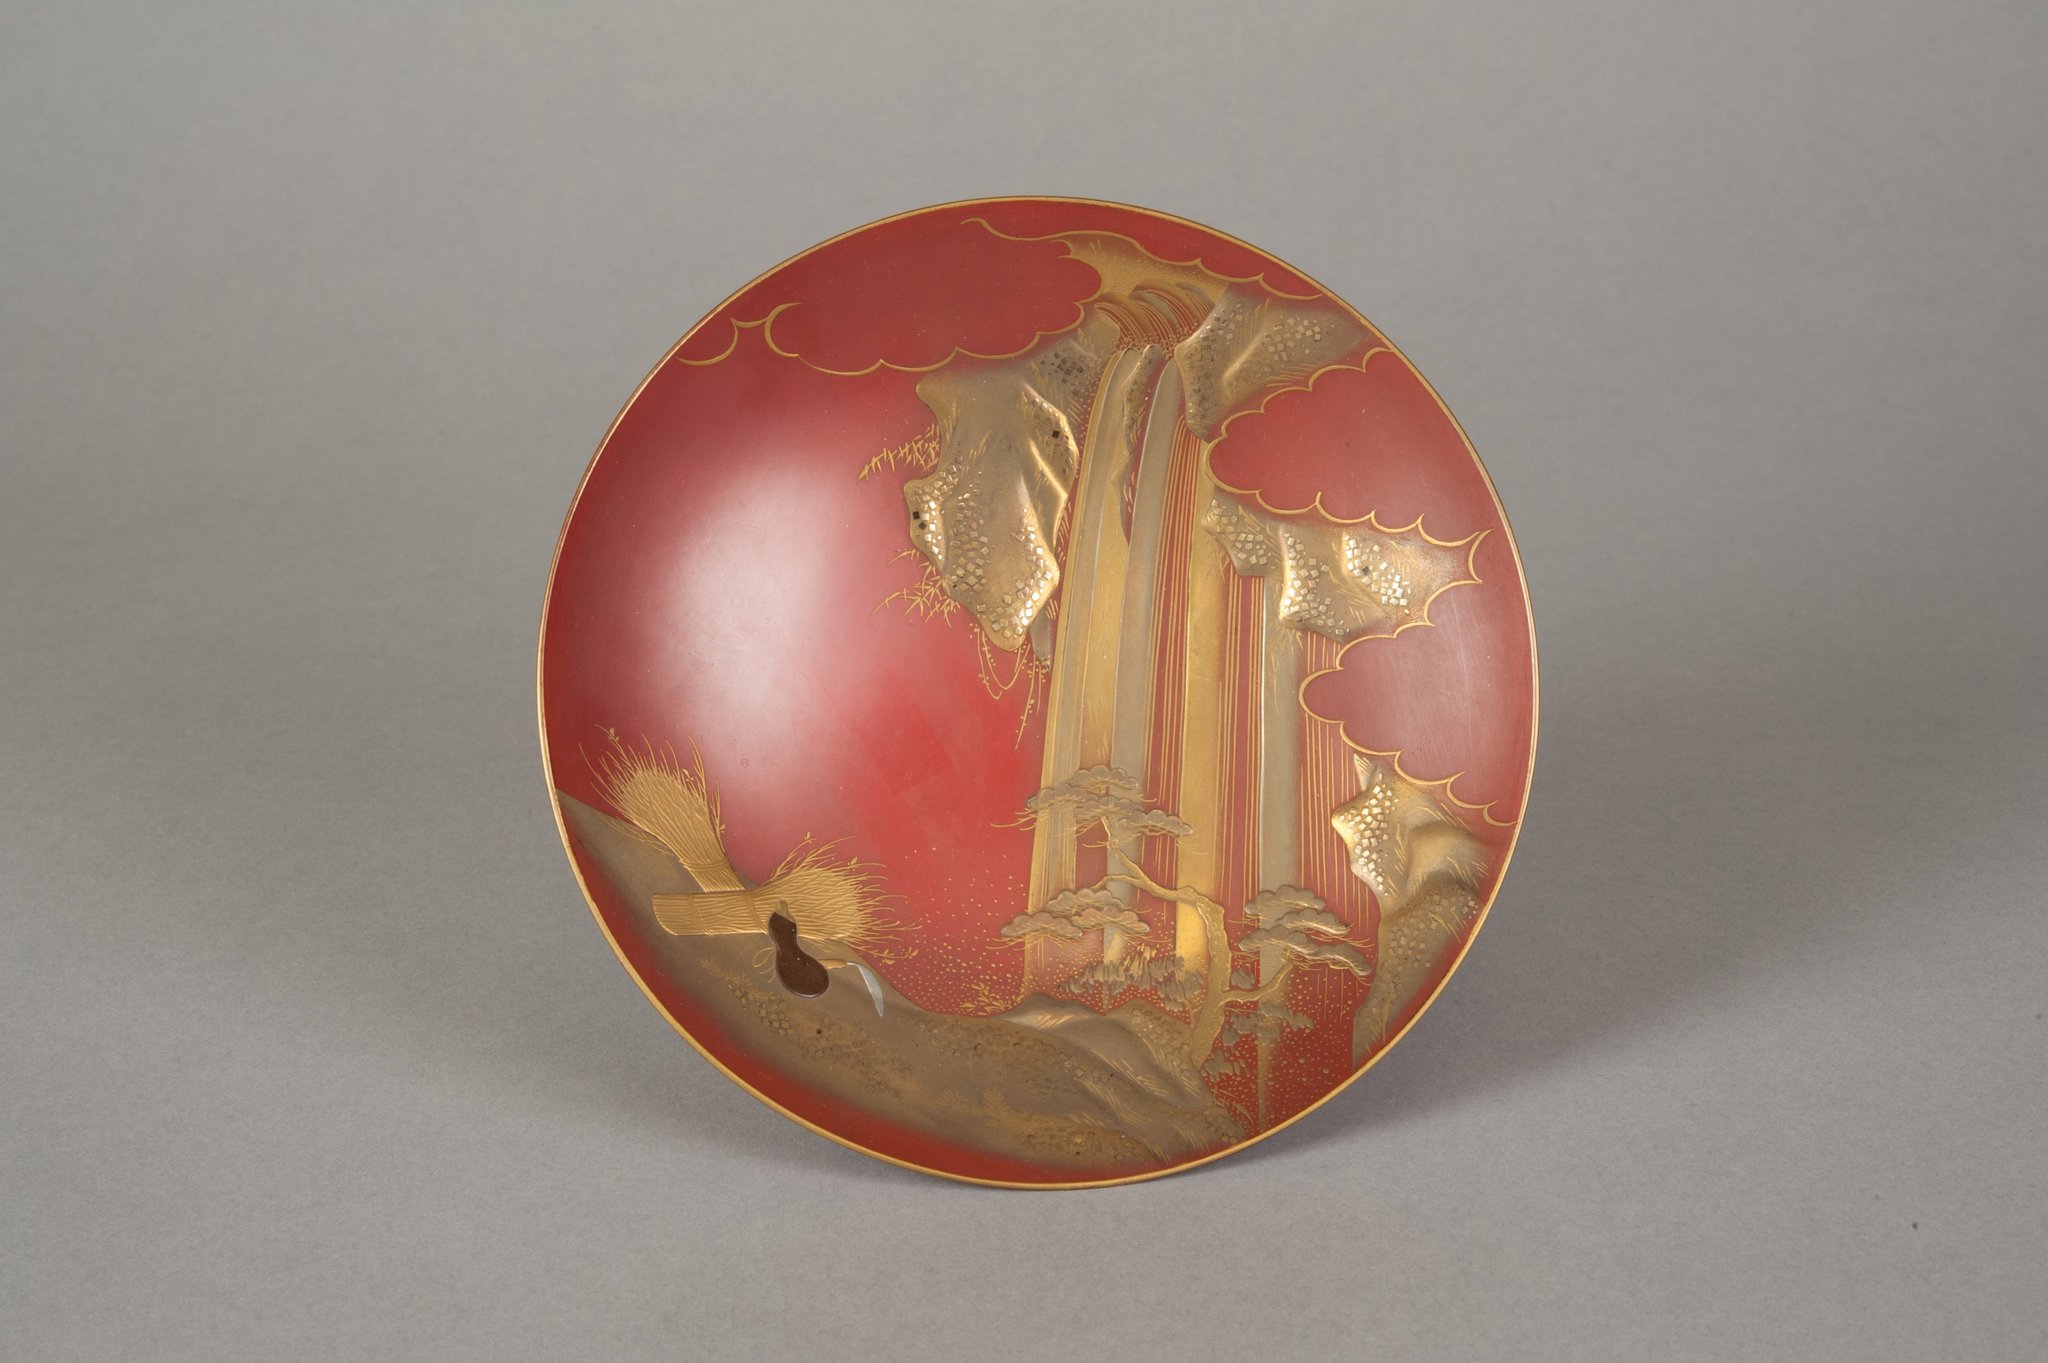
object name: sake cup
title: Sake Cup with Scenes from the Noh Plays Pine in the Winds, Yōrō Falls, and The Tengu of Mount Kurama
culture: japanese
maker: shomosai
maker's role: artist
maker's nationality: japanese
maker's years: 18-19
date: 1801-1850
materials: foil, gold, silver, wood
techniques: hiramakie, lacquer, maki-e